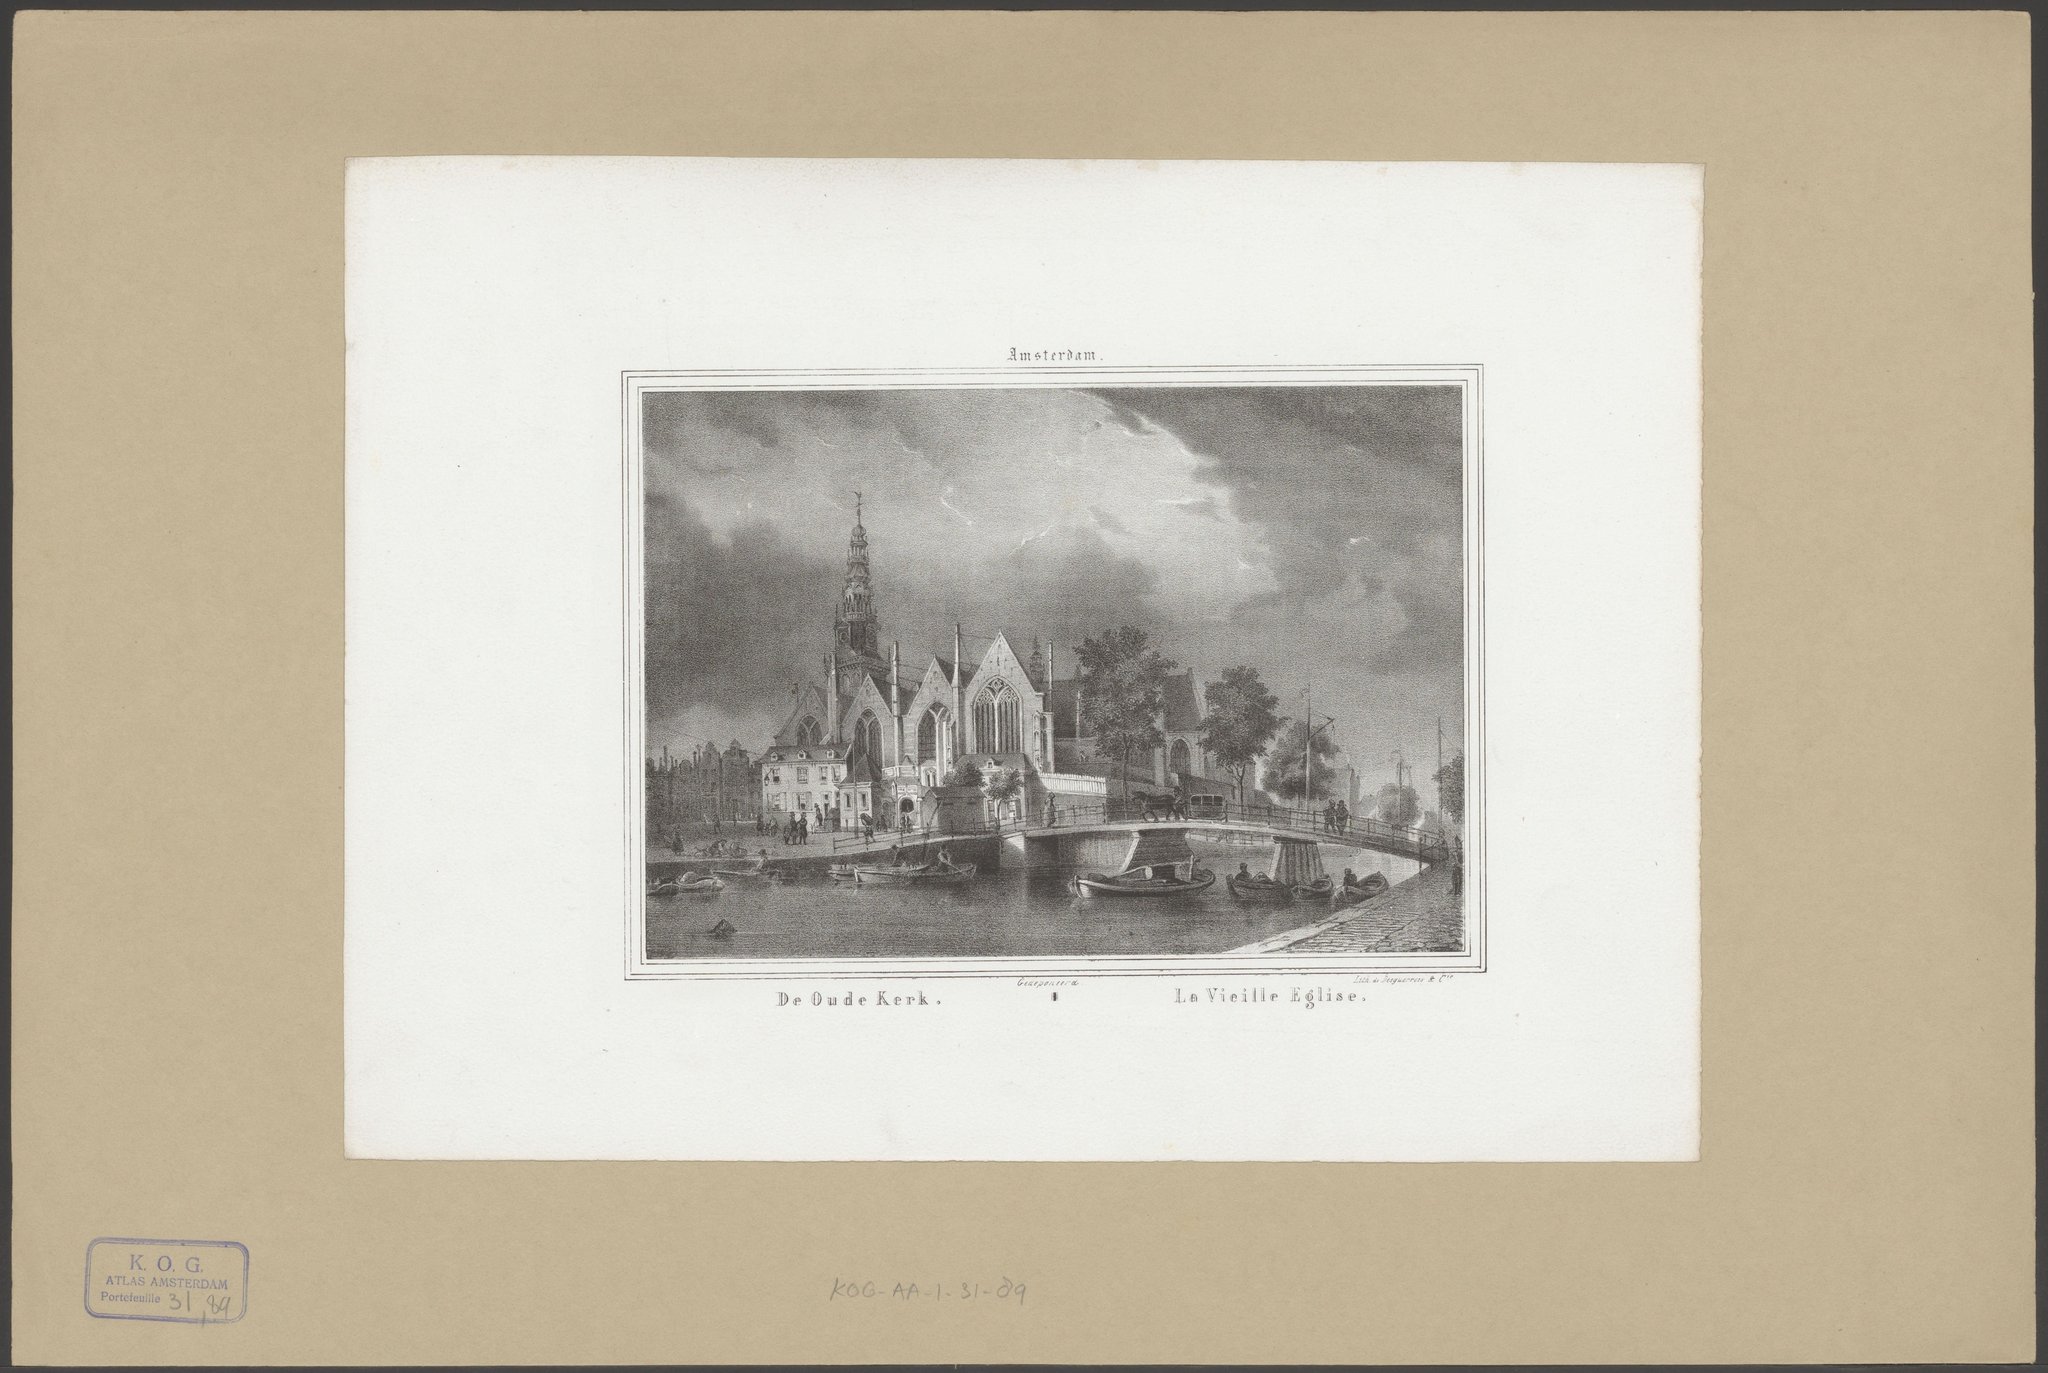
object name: print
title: Gezicht op de Oude Kerk te Amsterdam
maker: Anonymous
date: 1827-1900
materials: paper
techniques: lithograph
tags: church (exterior), canals, waters (in city), boat propelled by man or animal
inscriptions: : ‘Gedeponeerd’, collector's mark: ‘31.89’ Lugt 1641b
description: Onderwerpsrubriek binnen de Atlas Amsterdam: Kerkwezen: Hervormde Gemeente: Oude Kerk van buiten.